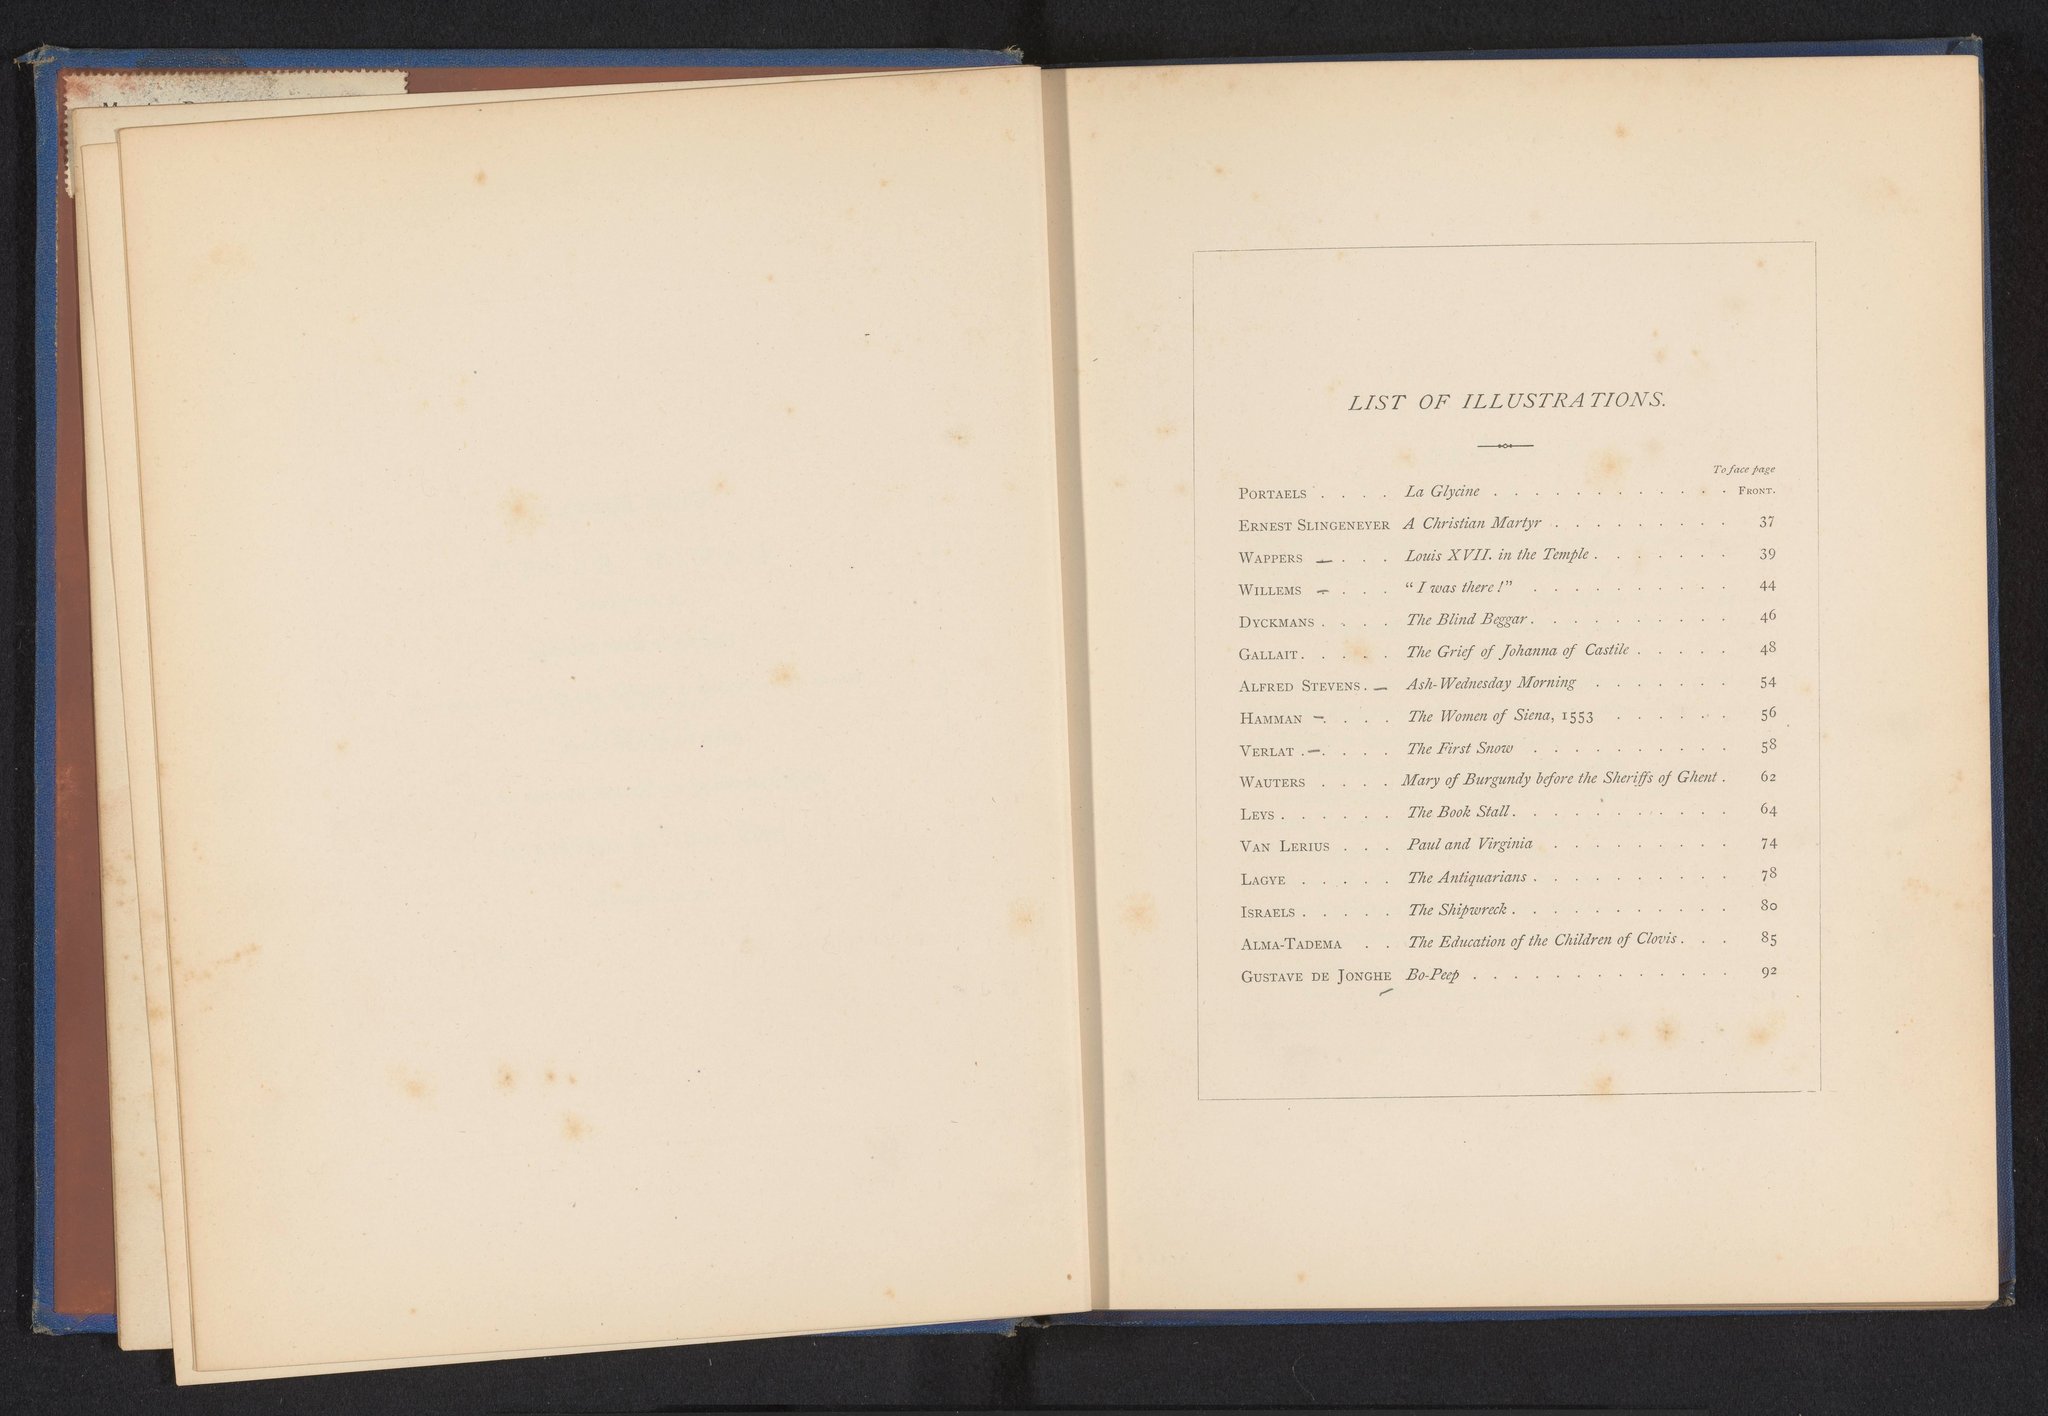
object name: book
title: Gems of modern Belgian art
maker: william bell scott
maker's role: draughtsman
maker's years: 1811-1890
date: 1872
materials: cardboard, linen, paper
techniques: printing, woodburytype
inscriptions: inscription: ‘ex libris SFJ’, inscription: ‘Monsieur Beaufort rue du Général Bertrand, 78 Liége’